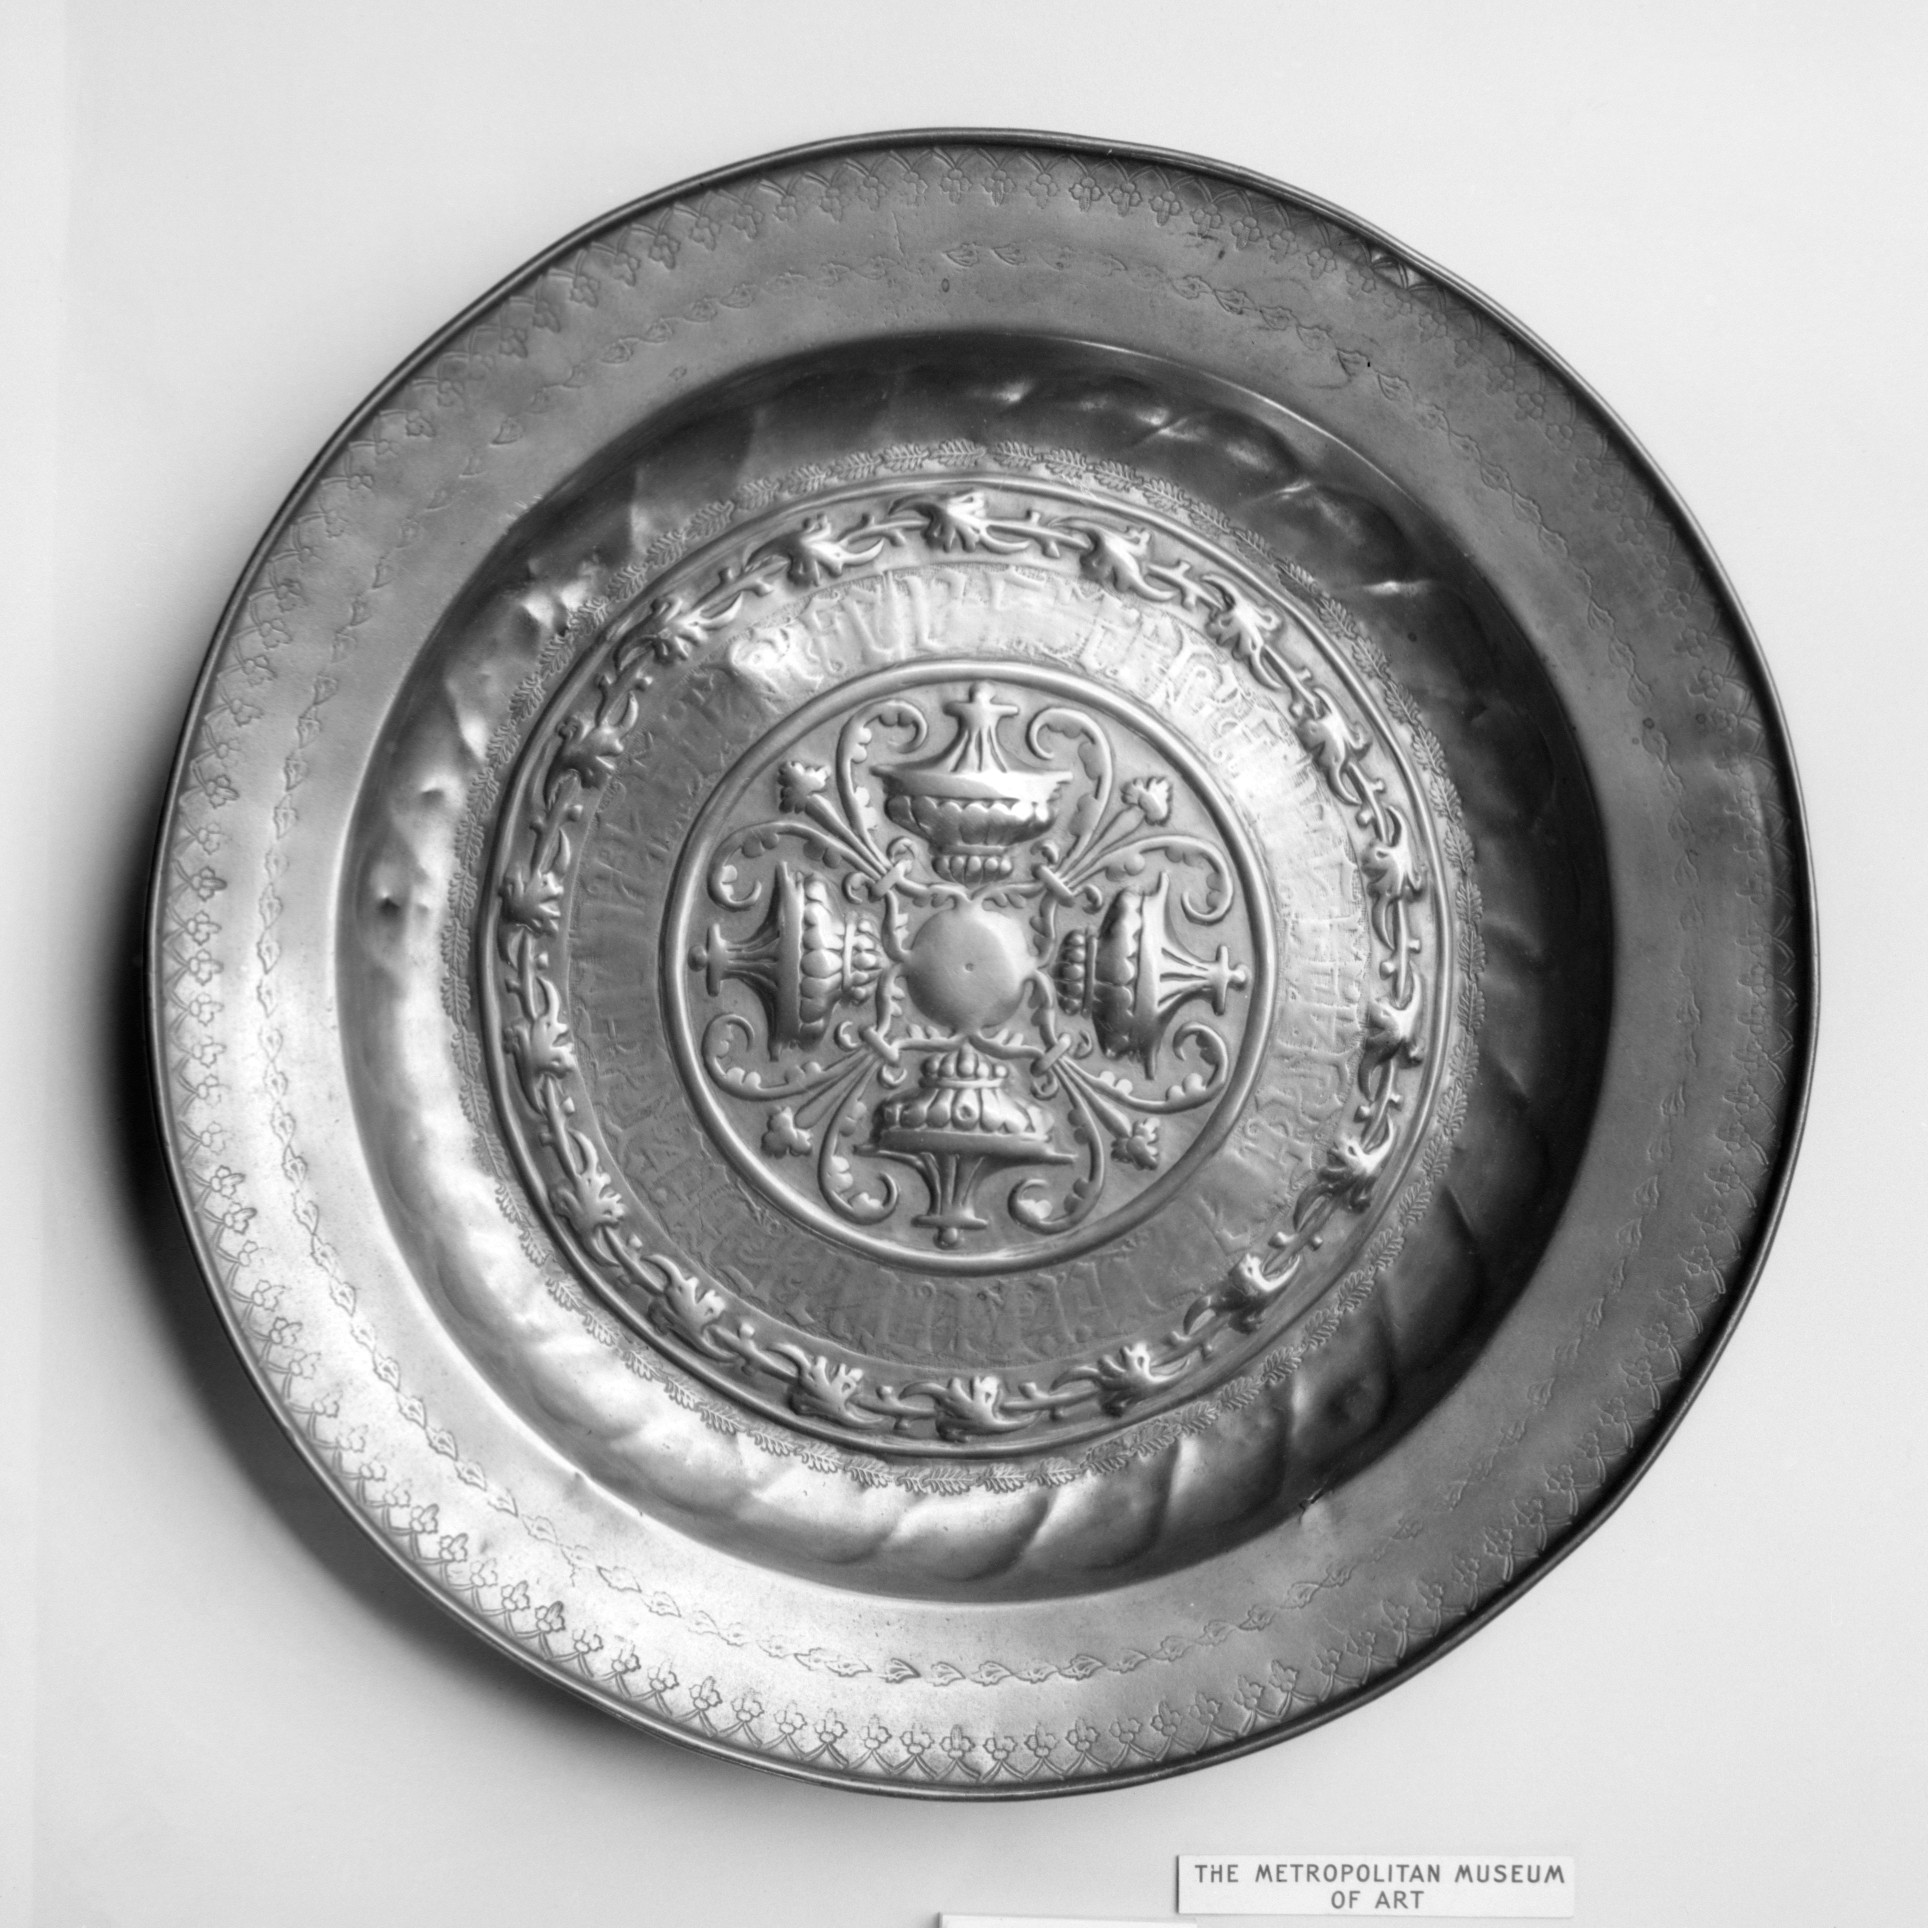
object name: dish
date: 1501-1600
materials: brass